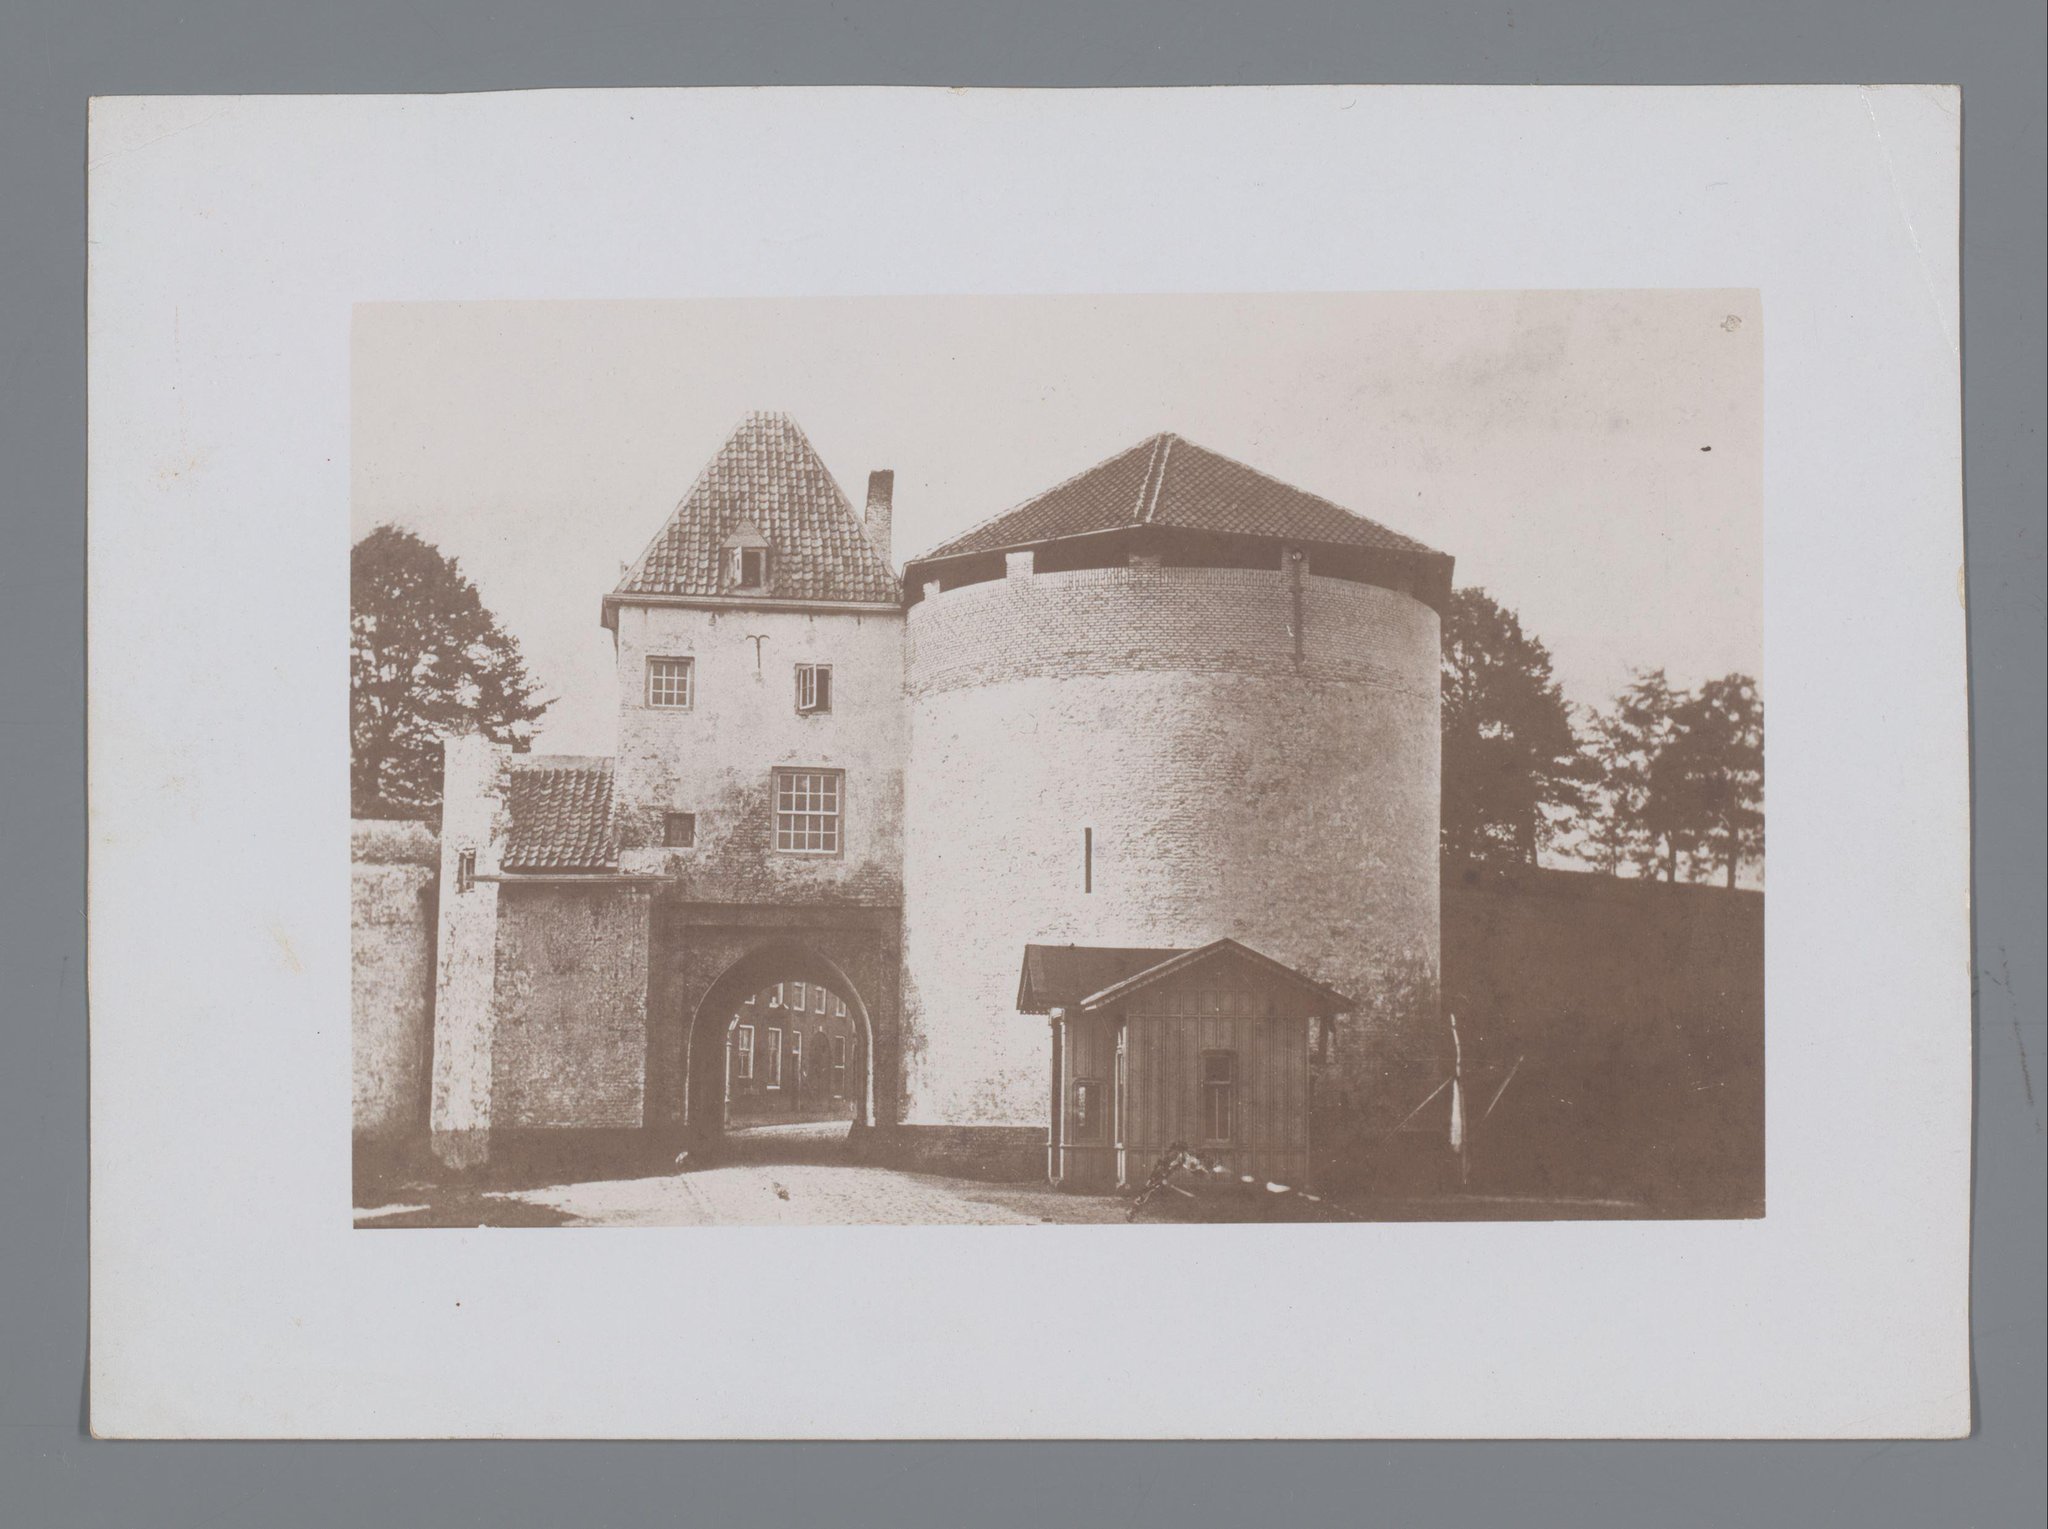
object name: photograph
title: Gezicht op de Hertogsteegpoort te Nijmegen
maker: Anonymous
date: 1880-1910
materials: photographic support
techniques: collodion silver print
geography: nijmegen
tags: city-gate, nijmegen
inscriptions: annotation: ‘Nijmegen?’